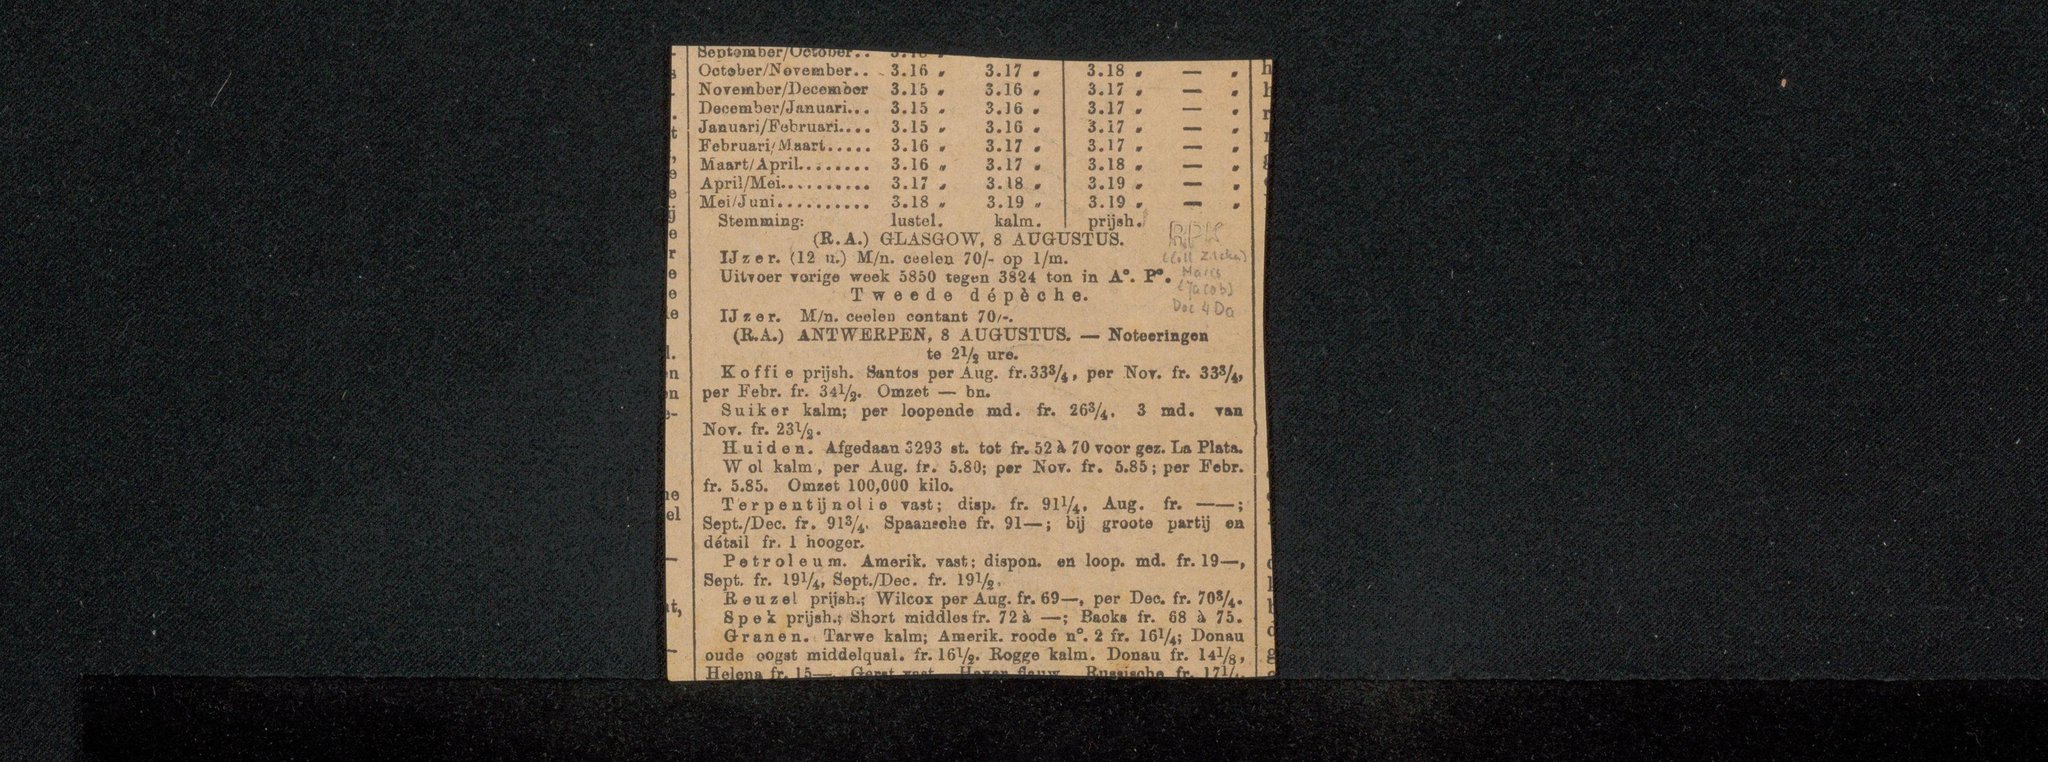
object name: newspaper clipping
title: Krantenknipsel uit archief Philip Zilcken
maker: Anonymous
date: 1899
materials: paper, ink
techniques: printing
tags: the hague, painter, draughtsman, jacob maris, philip zilcken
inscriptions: collector's mark: ‘RPK’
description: Krantenknipsel vormt samen met RP-D-1982-43-MARIS(JACOB)-DOC.4DB een doorlopend artikel.